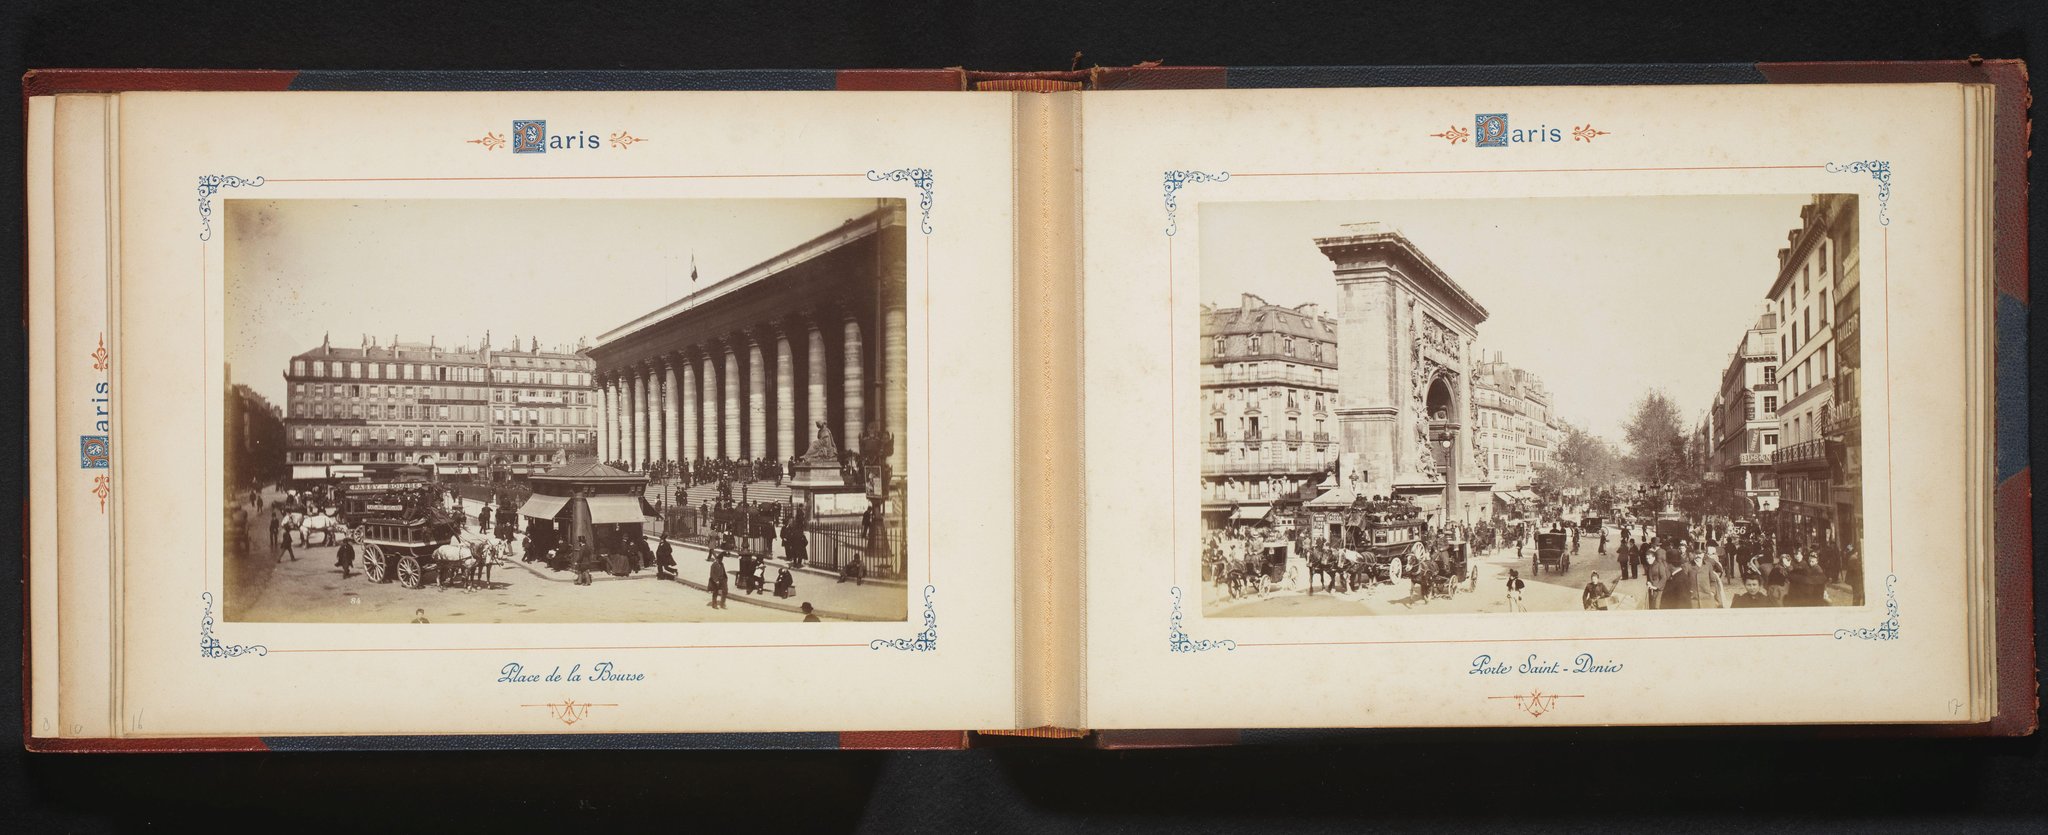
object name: photograph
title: Place de la Bourse te Parijs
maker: Anonymous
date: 1879-1889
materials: photographic support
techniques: albumen print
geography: paris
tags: square, place, circus, etc., stock exchange, stock-market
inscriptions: number: ‘84’